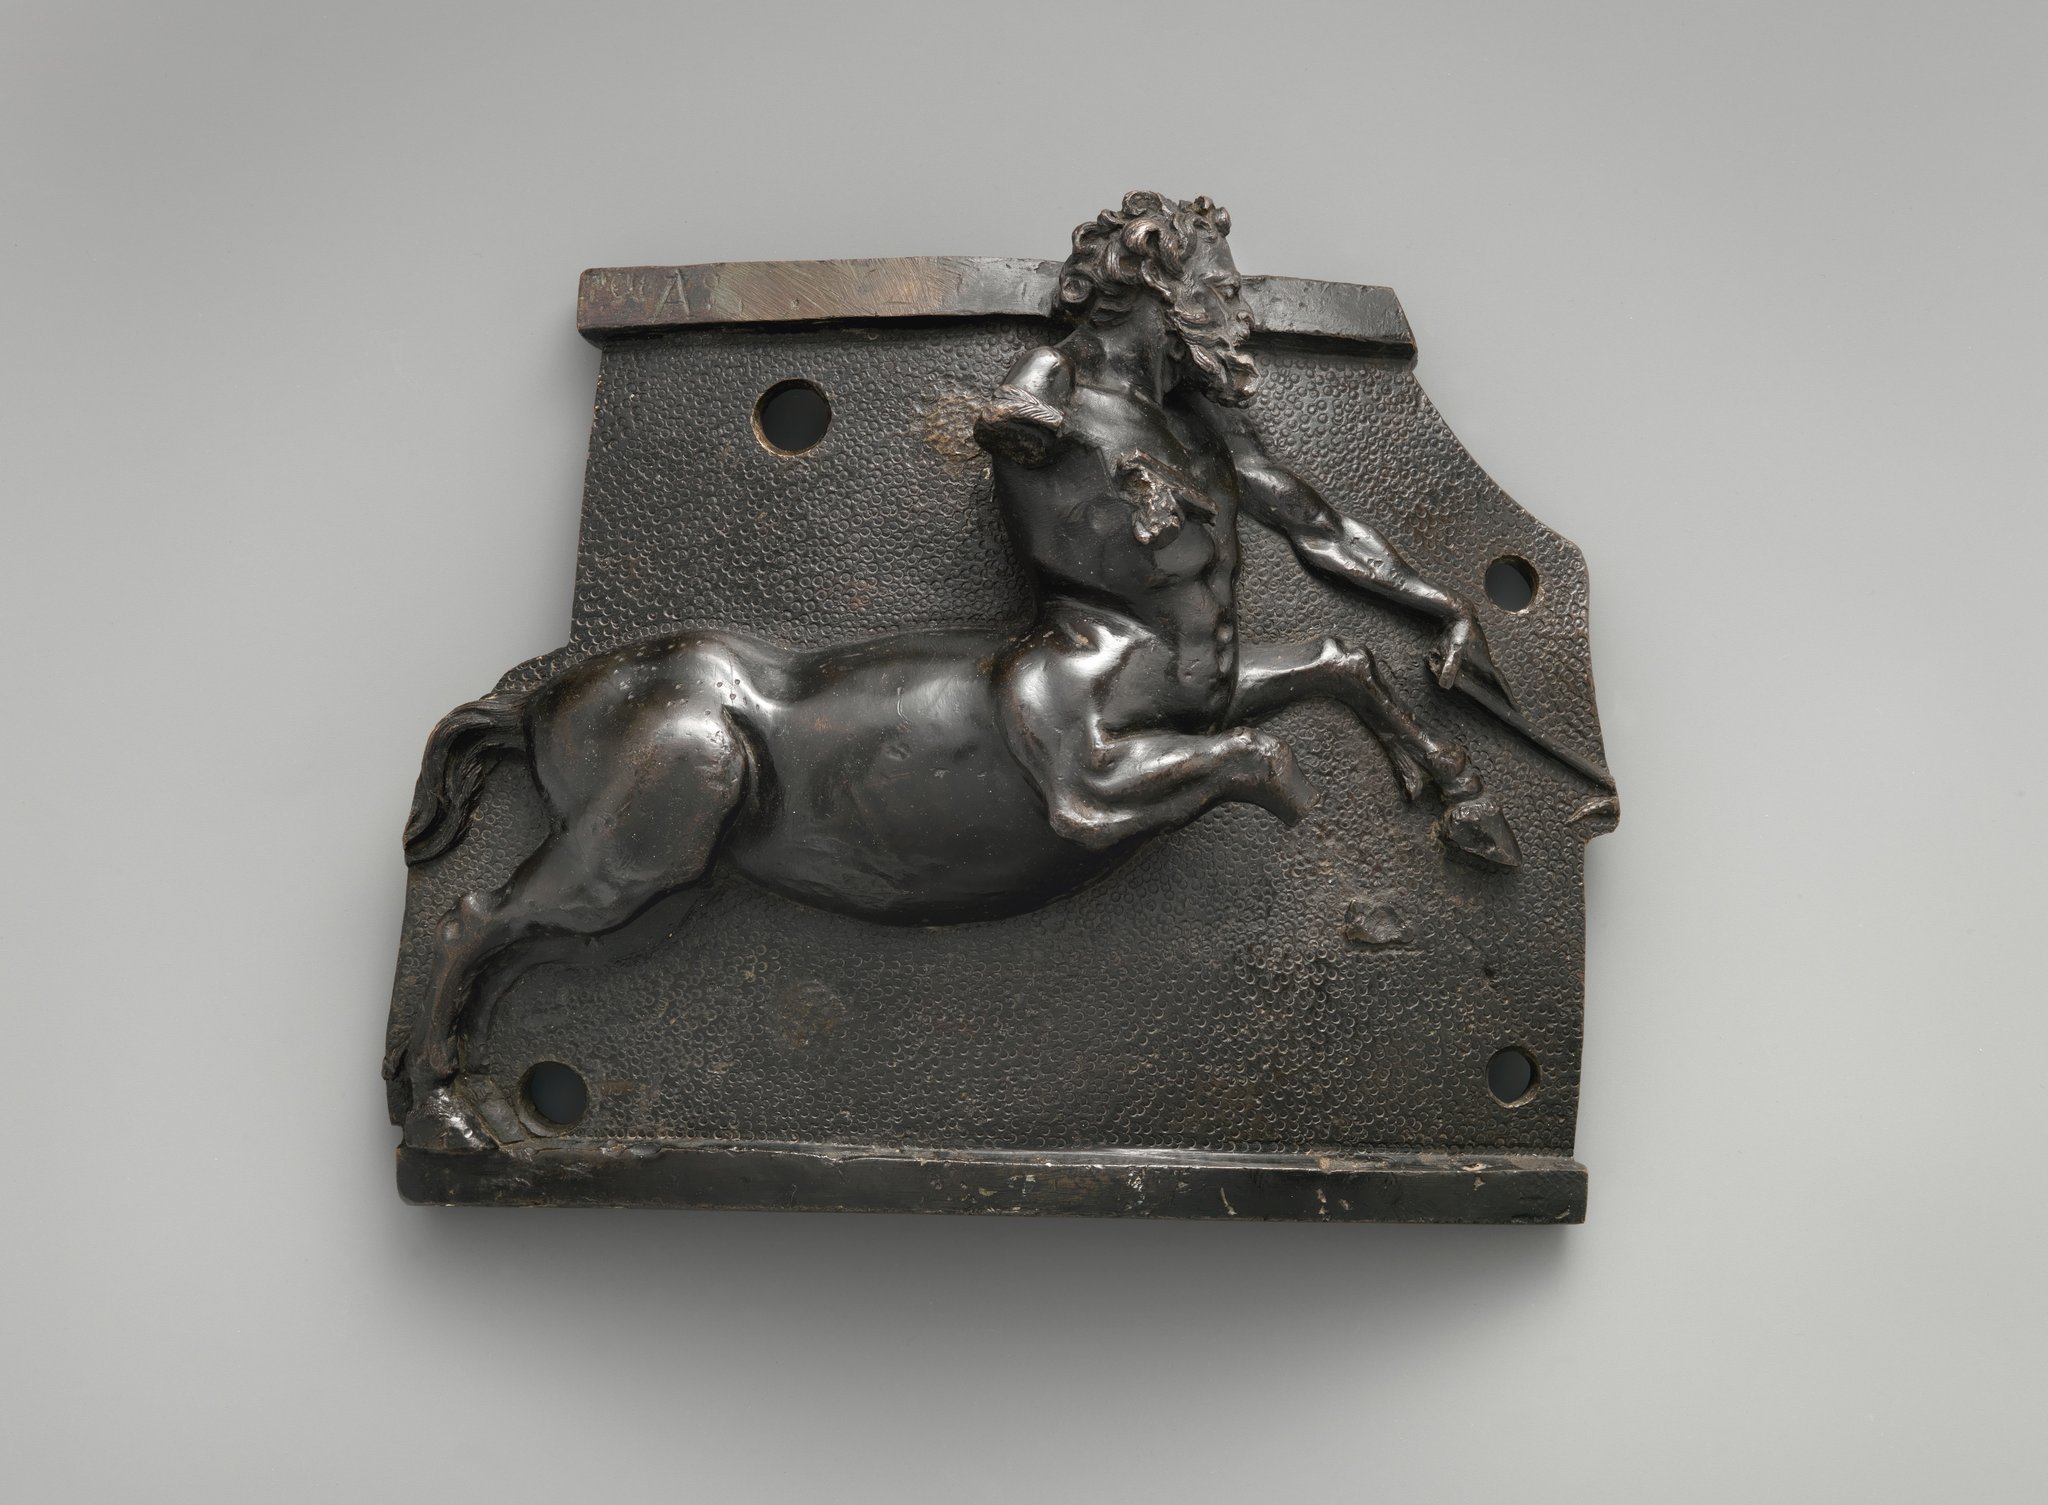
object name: frieze fragment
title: Sagittarius (section of a zodiac frieze)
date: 1582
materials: bronze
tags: centaurs